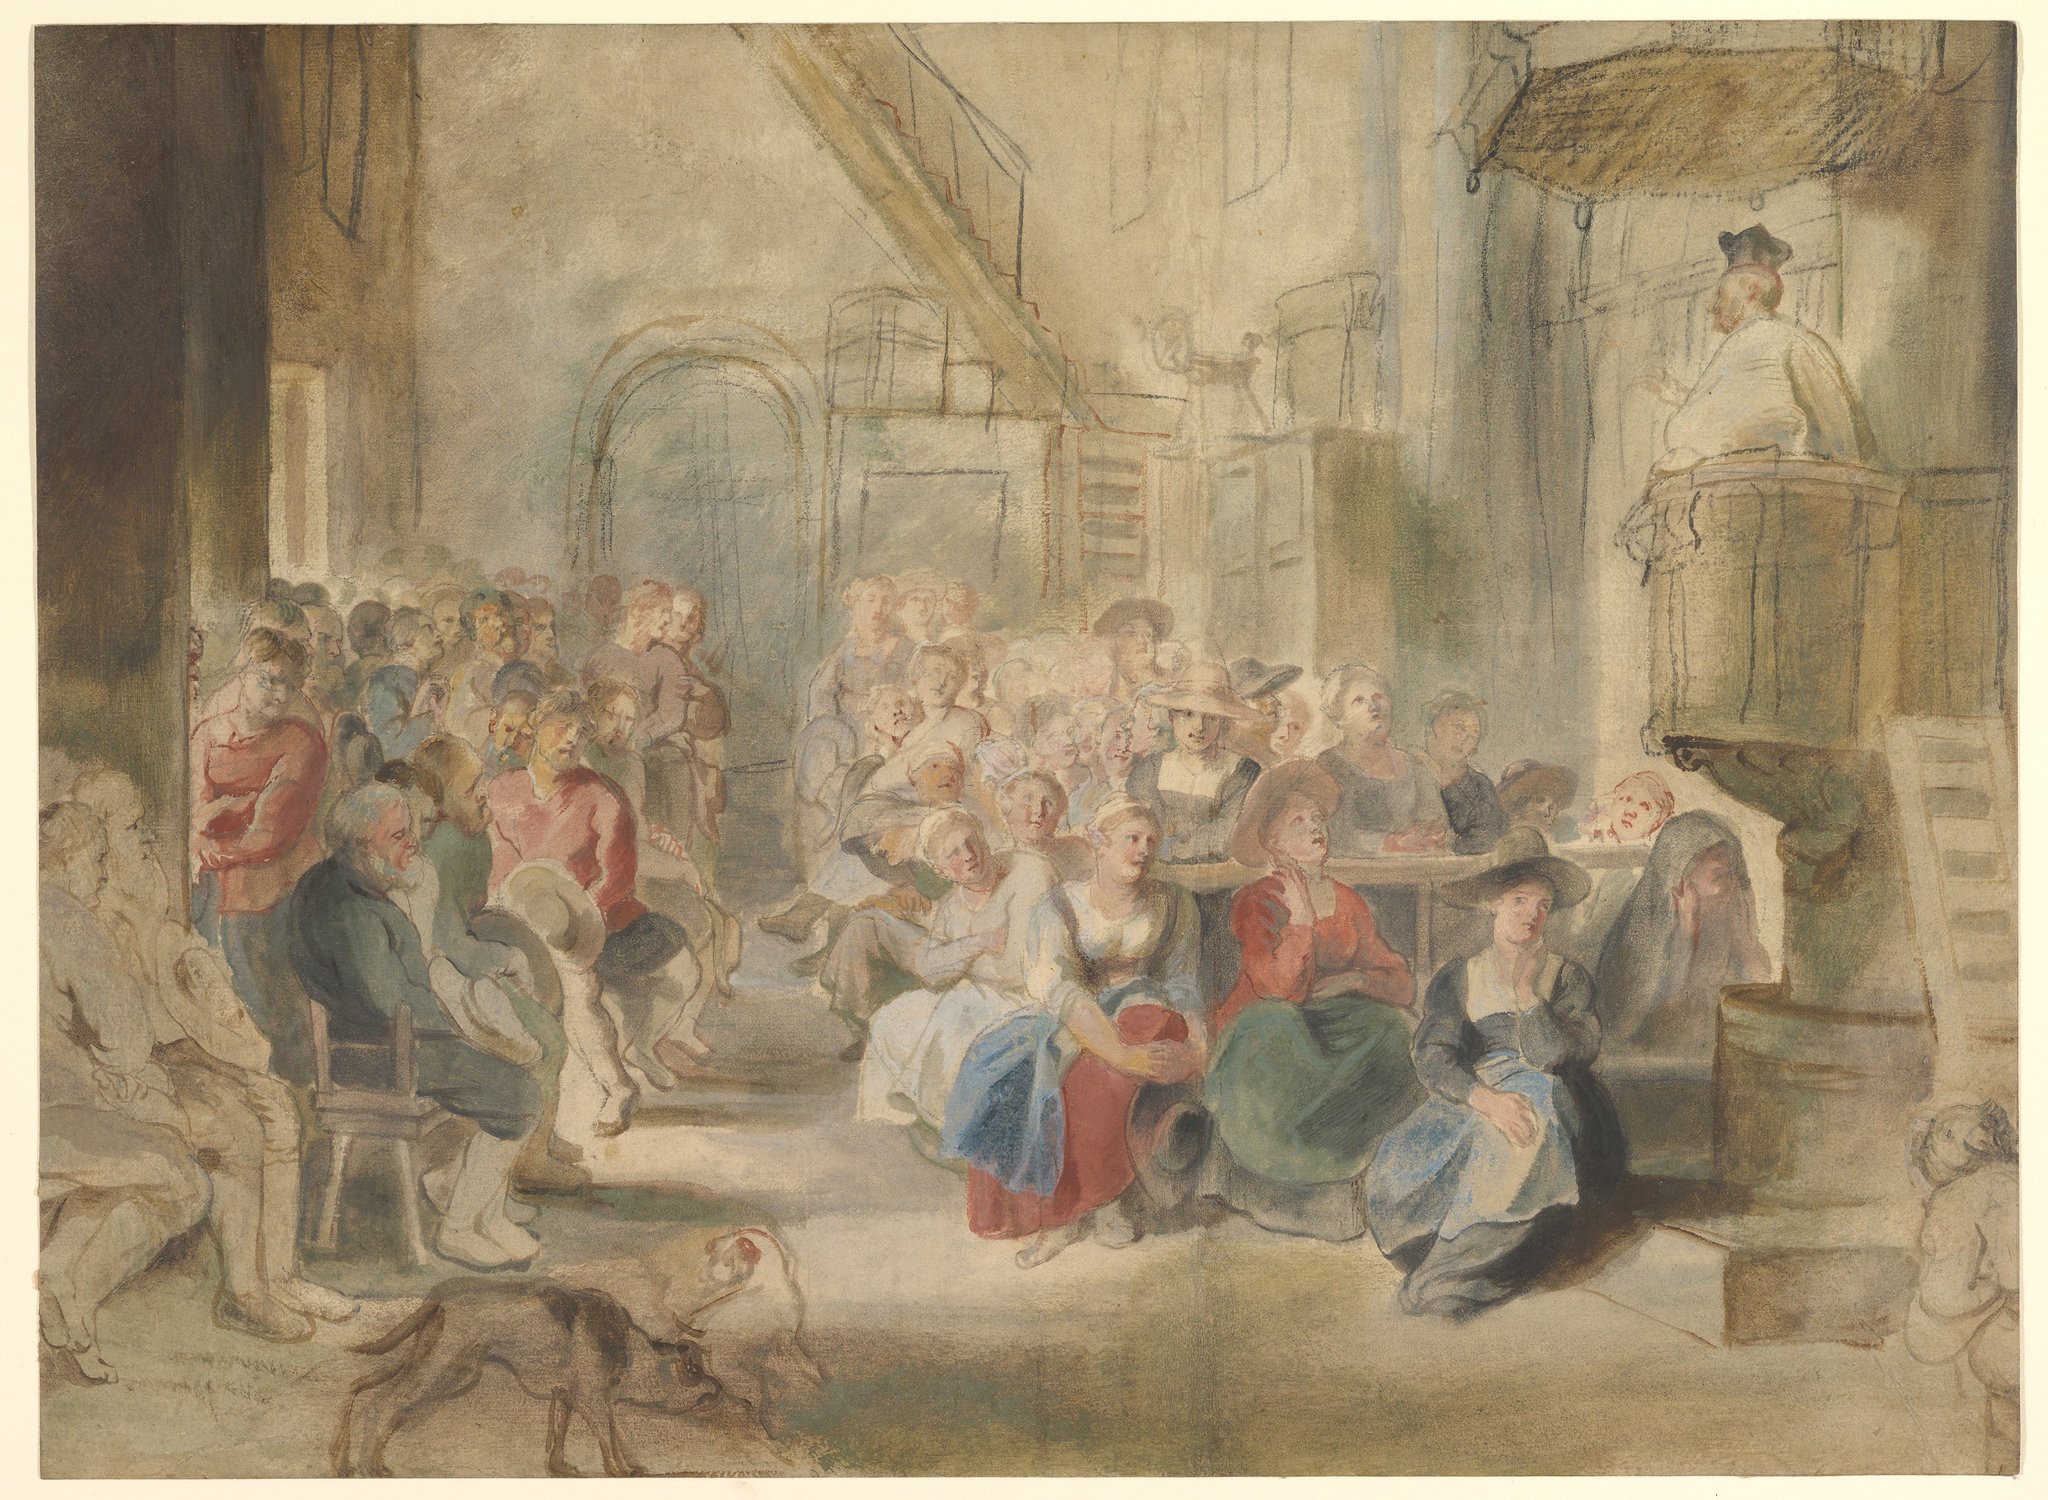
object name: drawing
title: A Sermon in a Village Church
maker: peter paul rubens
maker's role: artist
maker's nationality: flemish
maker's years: 1577-1640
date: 1630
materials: chalk, oil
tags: churches,men,women,dogs